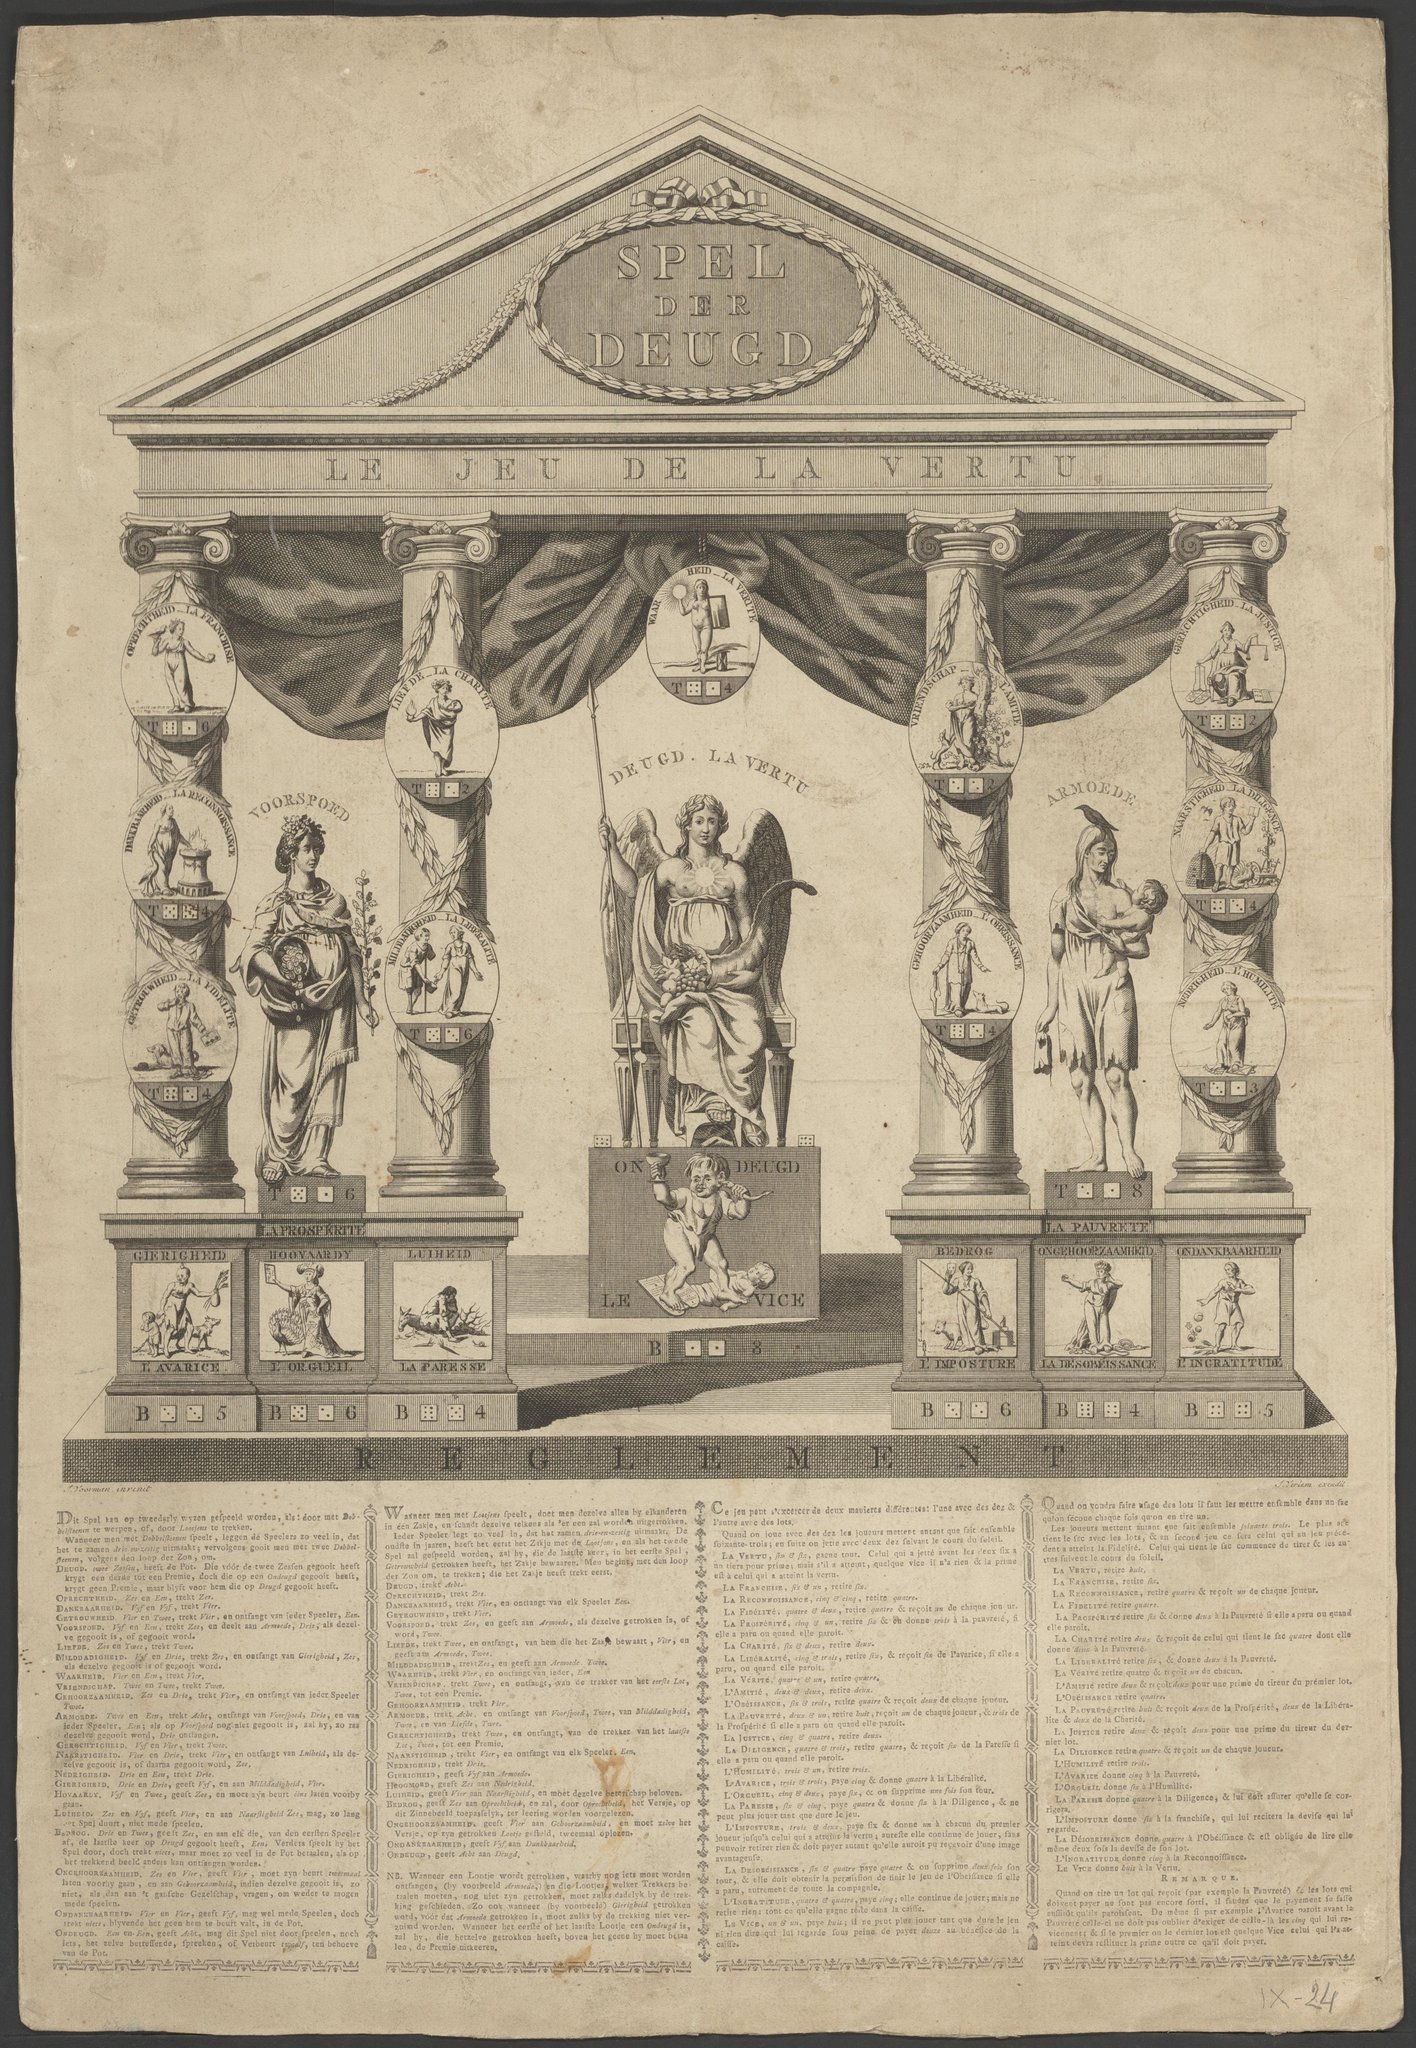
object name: print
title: Spel der Deugd / Le Jeu de la Vertu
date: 1798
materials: cardboard, paper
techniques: etching, letterpress printing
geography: netherlands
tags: figure representing a virtue vs. a vice, board-games of chance, strife between virtues and vices, psychomachy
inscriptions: collector's mark: Lugt 1641, collector's mark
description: Een bouwwerk met vier Ionische zuilen en een fronton waarin links de personificatie van Voorspoed met een hoorn met munten en een tak met eikenbladeren. Links en rechts van haar medaillons met personificaties van Oprechtheid, Dankbaarheid, Getrouwheid, Liefde en Milddadigheid. Daaronder weergaven van Gierigheid, Hoovaardy en Luiheid. In het midden de gevleugelde Deugd met een speer, een lauwerkrans en een hoorn des overvloeds. Ze troont op een verhoging waarop de Ondeugd, die de tafelen met de tien geboden en een kind vertrapt. Rechts staat de in lompen gehulde Armoede met een kind op haar arm tussen medaillons met Vriendschap, Gehoorzaamheid, Gerechtigheid, Naarstigheid en Nederigheid. Onder weergaven van Bedrog, Ongehoorzaamheid en Ondankbaarheid. De opschriften bij de personificaties zijn in het Nederlands en in het Frans. Onder de voorstelling het reglement in het Nederlands en in het Frans. Onderwerpsrubrieken binnen de Atlas Zeden en Gewoonten: Spel en Vermaak; gezelschapsspel, ganzenbord en dergelijke.